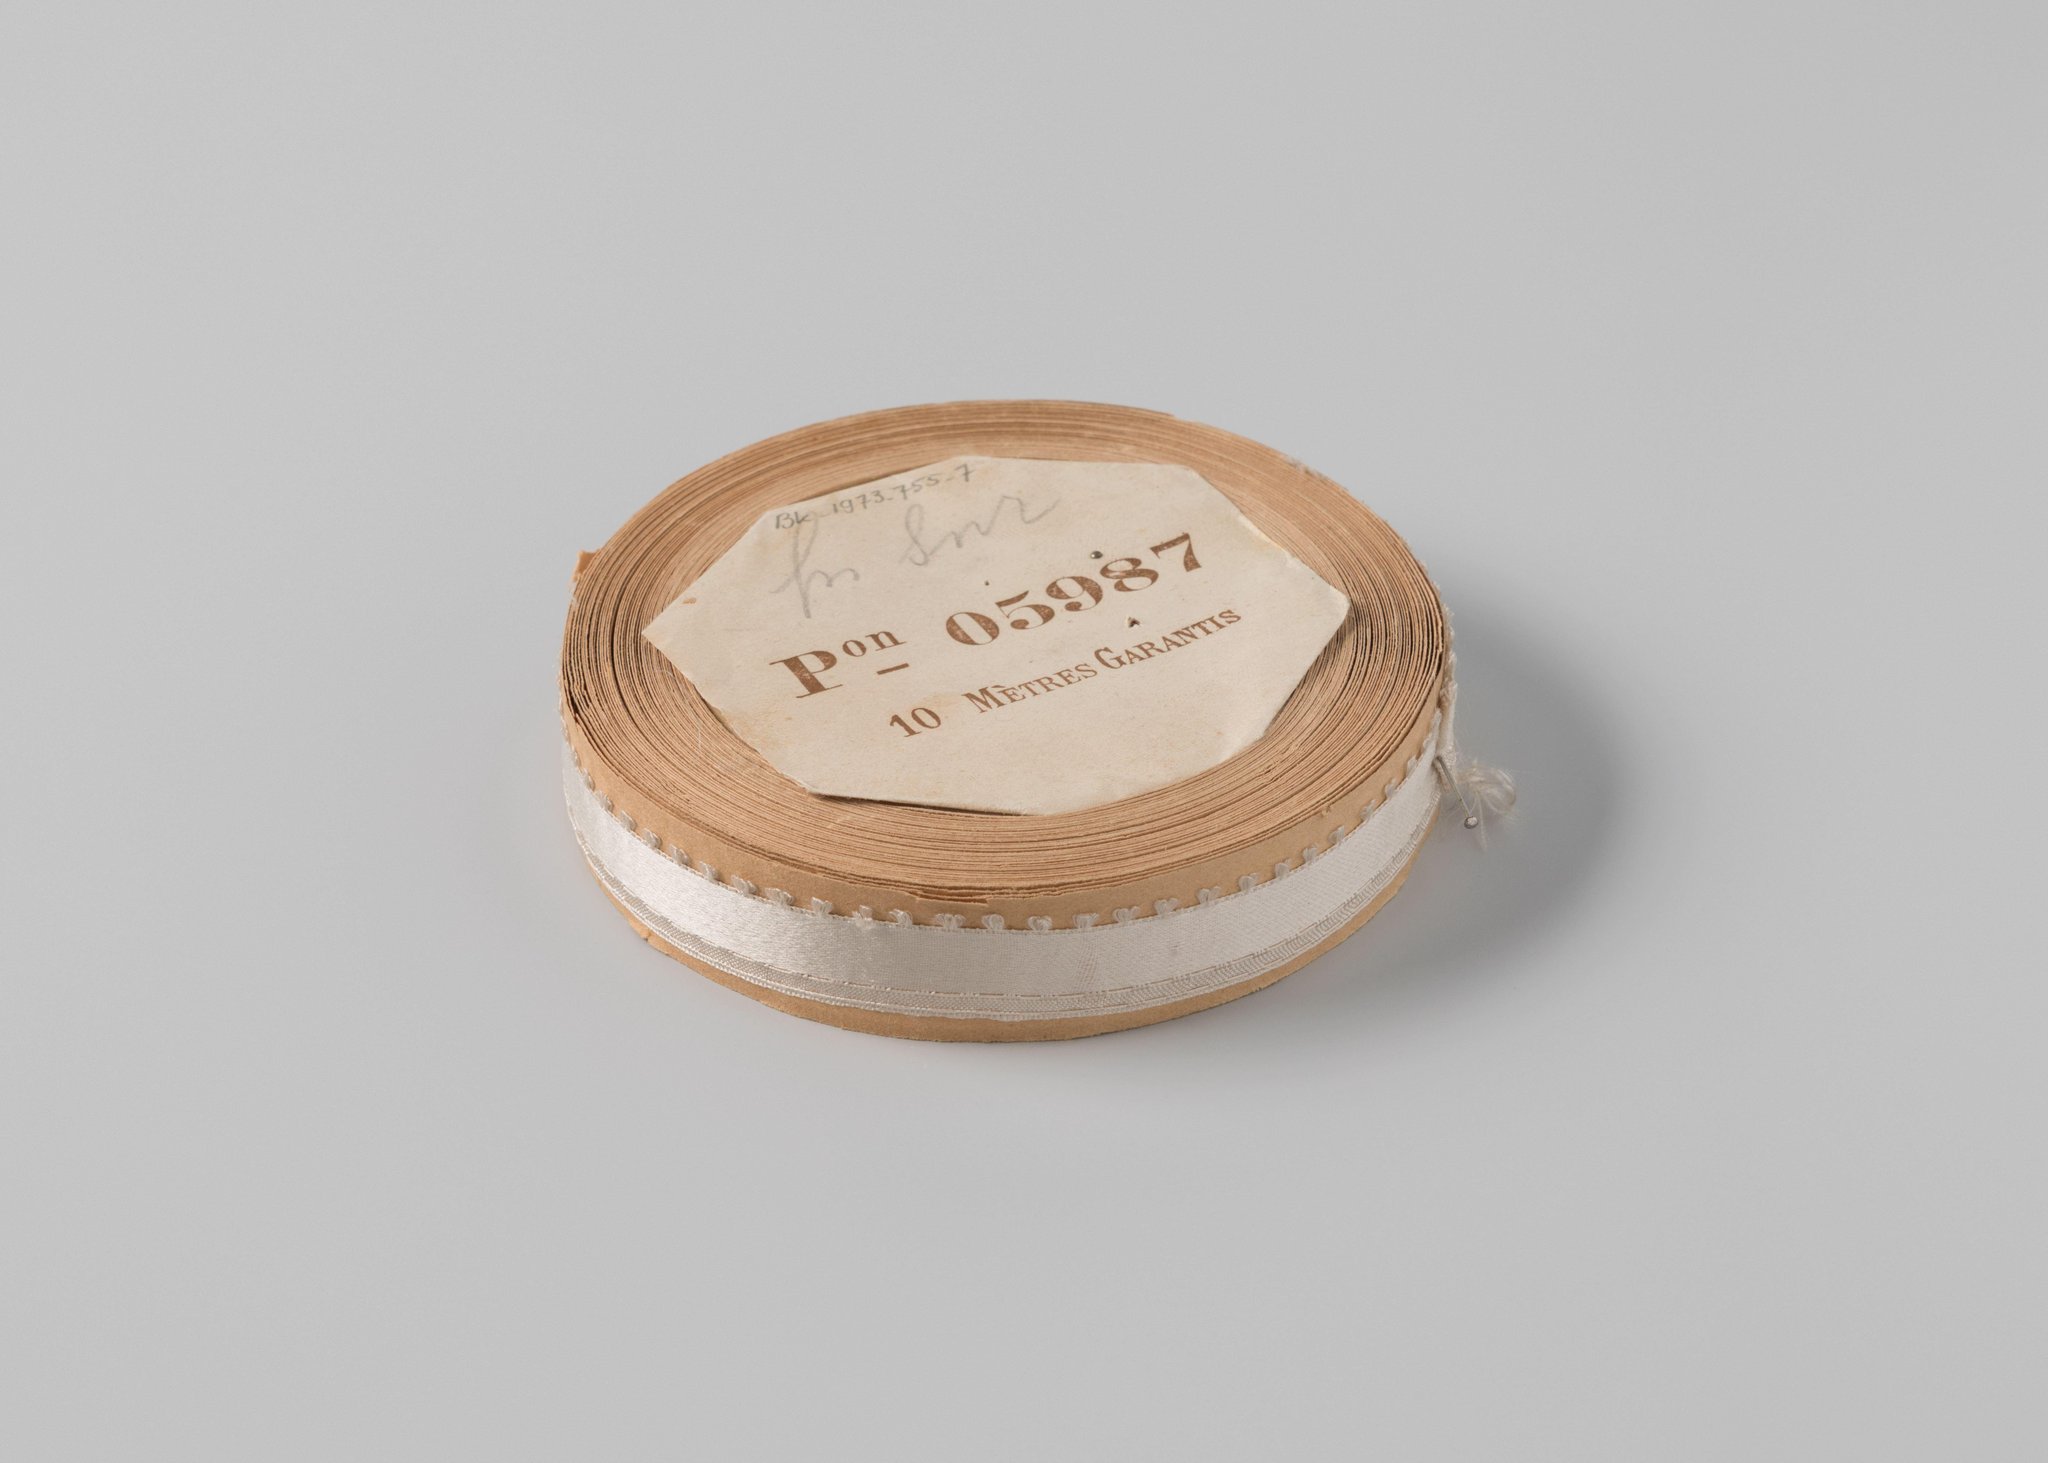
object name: braid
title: Lint op rol, wit satijn met één zijde voorzien van picots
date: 1890-1935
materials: cardboard, paper, textile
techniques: weave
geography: nijmegen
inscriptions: number: ‘Pon 05987’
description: Lint op rol, wit satijn met één zijde voorzien van picots.